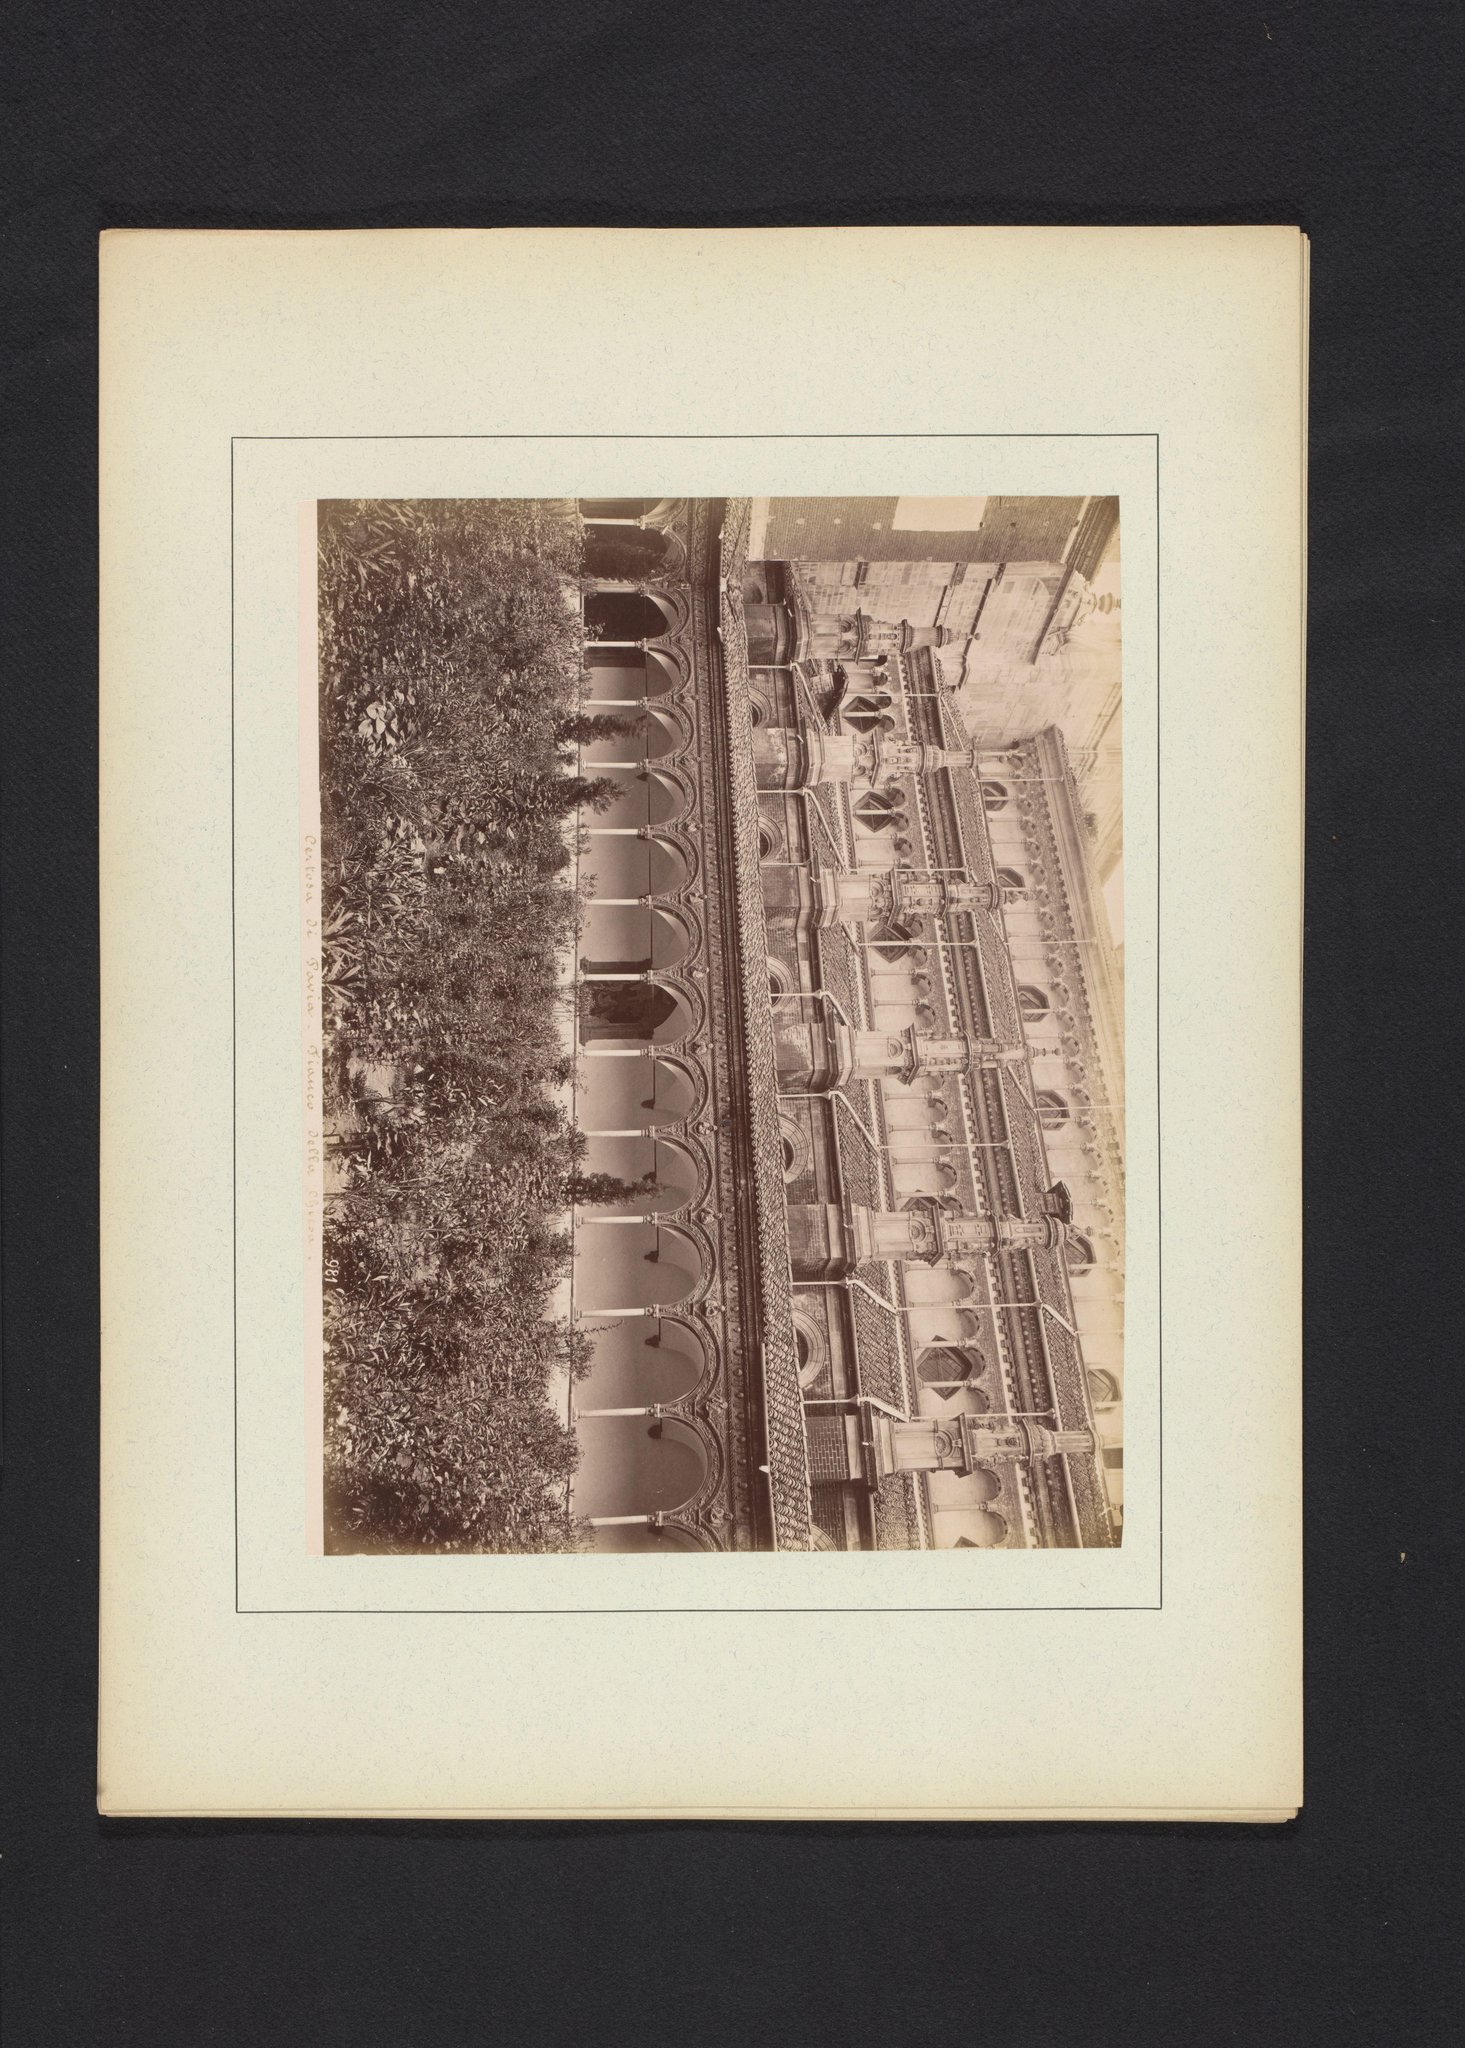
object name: photograph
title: Kerkzijde van de Certosa di Pavia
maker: alfredo noack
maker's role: fotograaf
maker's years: 1833-1895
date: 1877-1882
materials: cardboard, photographic support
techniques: albumen print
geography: certosa di pavia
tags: abbey, monastery, convent ~ roman catholic church, church (exterior)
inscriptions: number: ‘981’, inscription: ‘No. 7. Kleiner Klosterhof und Seitansicht der Kirche.’